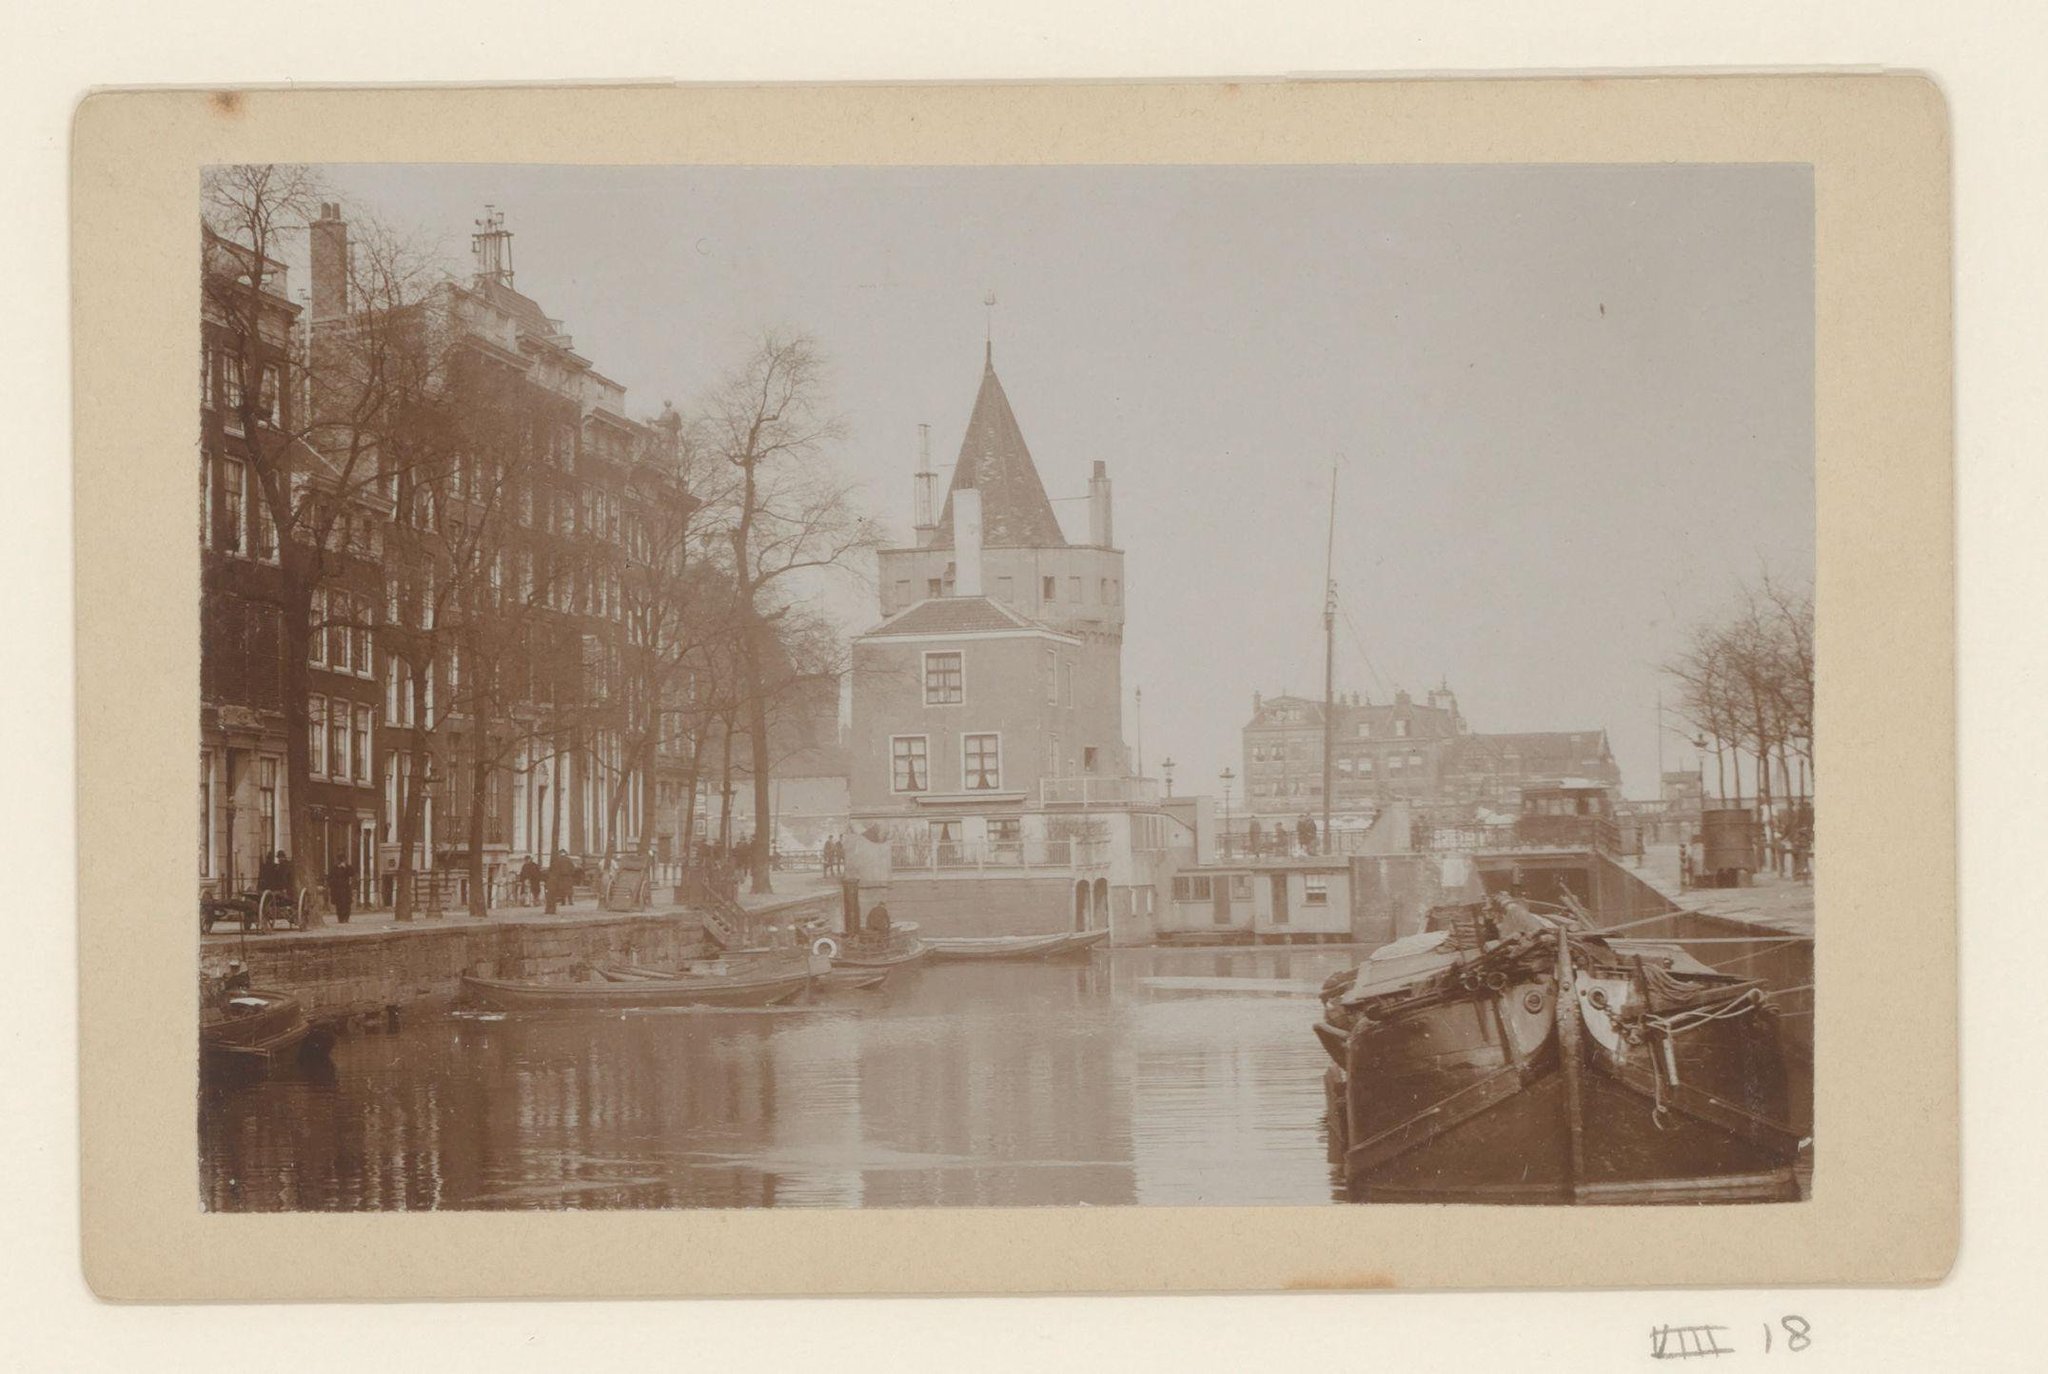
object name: cabinet photograph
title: Gezicht op de Schreierstoren aan de Geldersekade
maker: Anonymous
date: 1880-1920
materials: paper, cardboard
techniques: collodion silver print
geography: amsterdam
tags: city-view in general; 'veduta', towers ~ fortified city, quay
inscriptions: collector's mark: ‘8’ Lugt 1641b, inscription: ‘No 3 Schreijerstoren / Kloveniersburgwal / Geldersekade’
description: Onderwerpsrubriek binnen de Atlas Amsterdam: Galerij Paleis voor Volksvlijt, Gebed zonder end, Geldersche Kade, Gravenstraat, Grimburgwal, Grimnessesluis, Groeneburgwal.